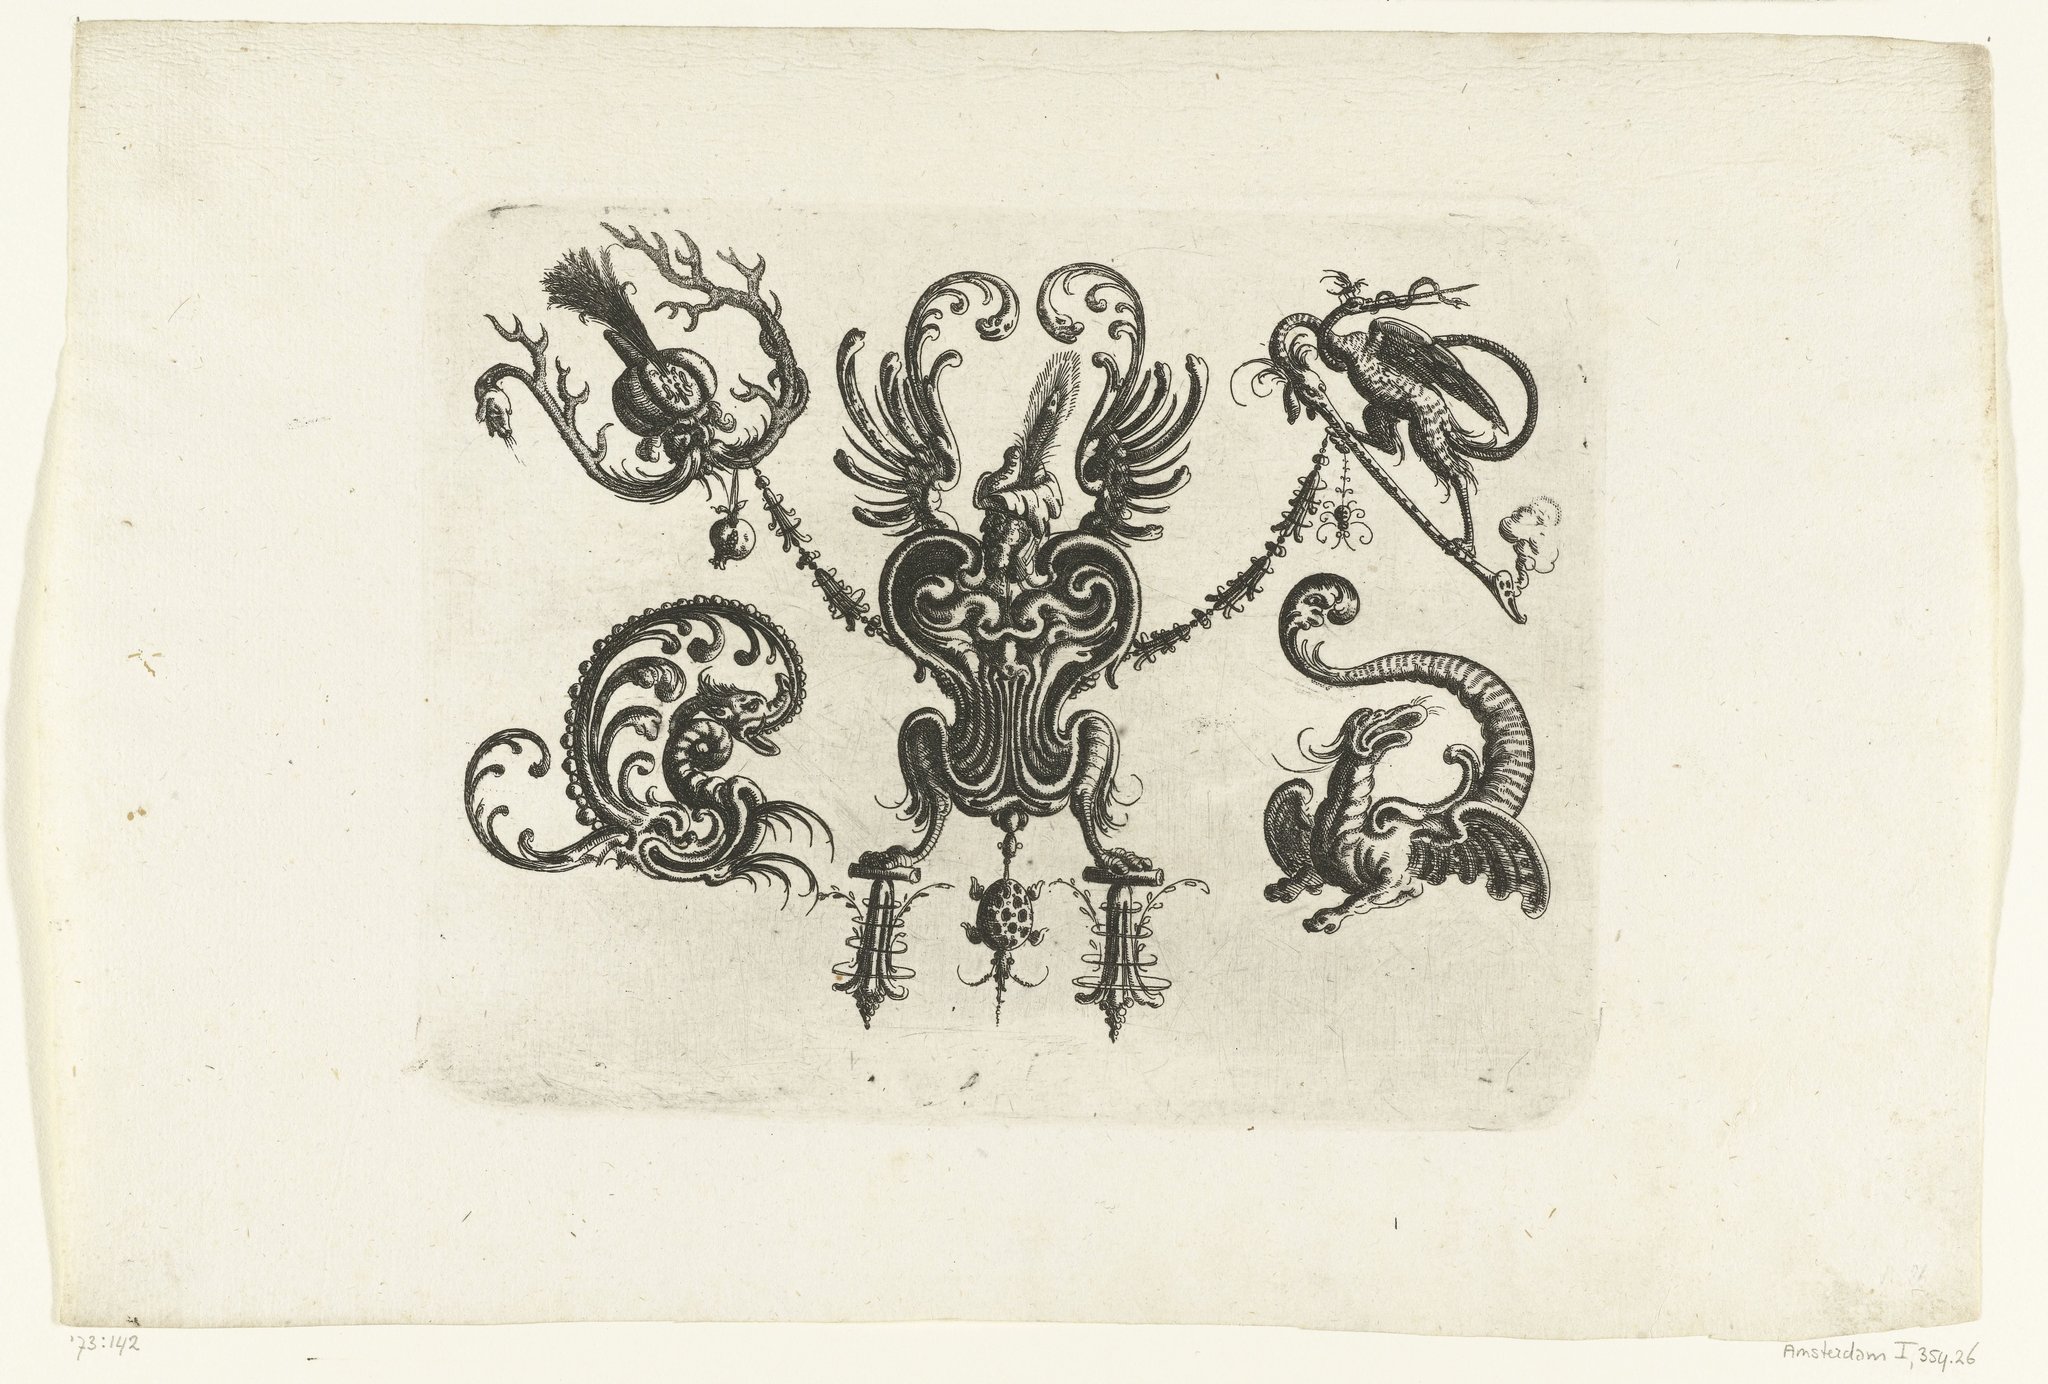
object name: ornament print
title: Sater met een mascaron als lichaam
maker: christoph jamnitzer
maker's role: draughtsman, goldsmith, print maker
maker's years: 1563-1618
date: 1573-1610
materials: paper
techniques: etching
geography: germany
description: De sater heeft vleugels en een muts op met een vis als veer. Blad uit een serie vlakdecoraties met grotesken, cartouches, ovalen, mascarons, putti en fantastische wezens. De serie bestaat uit drie titelbladen, twee tekstbladen met de opdracht en het voorwoord en 60 bladen, verdeeld over drie boeken.